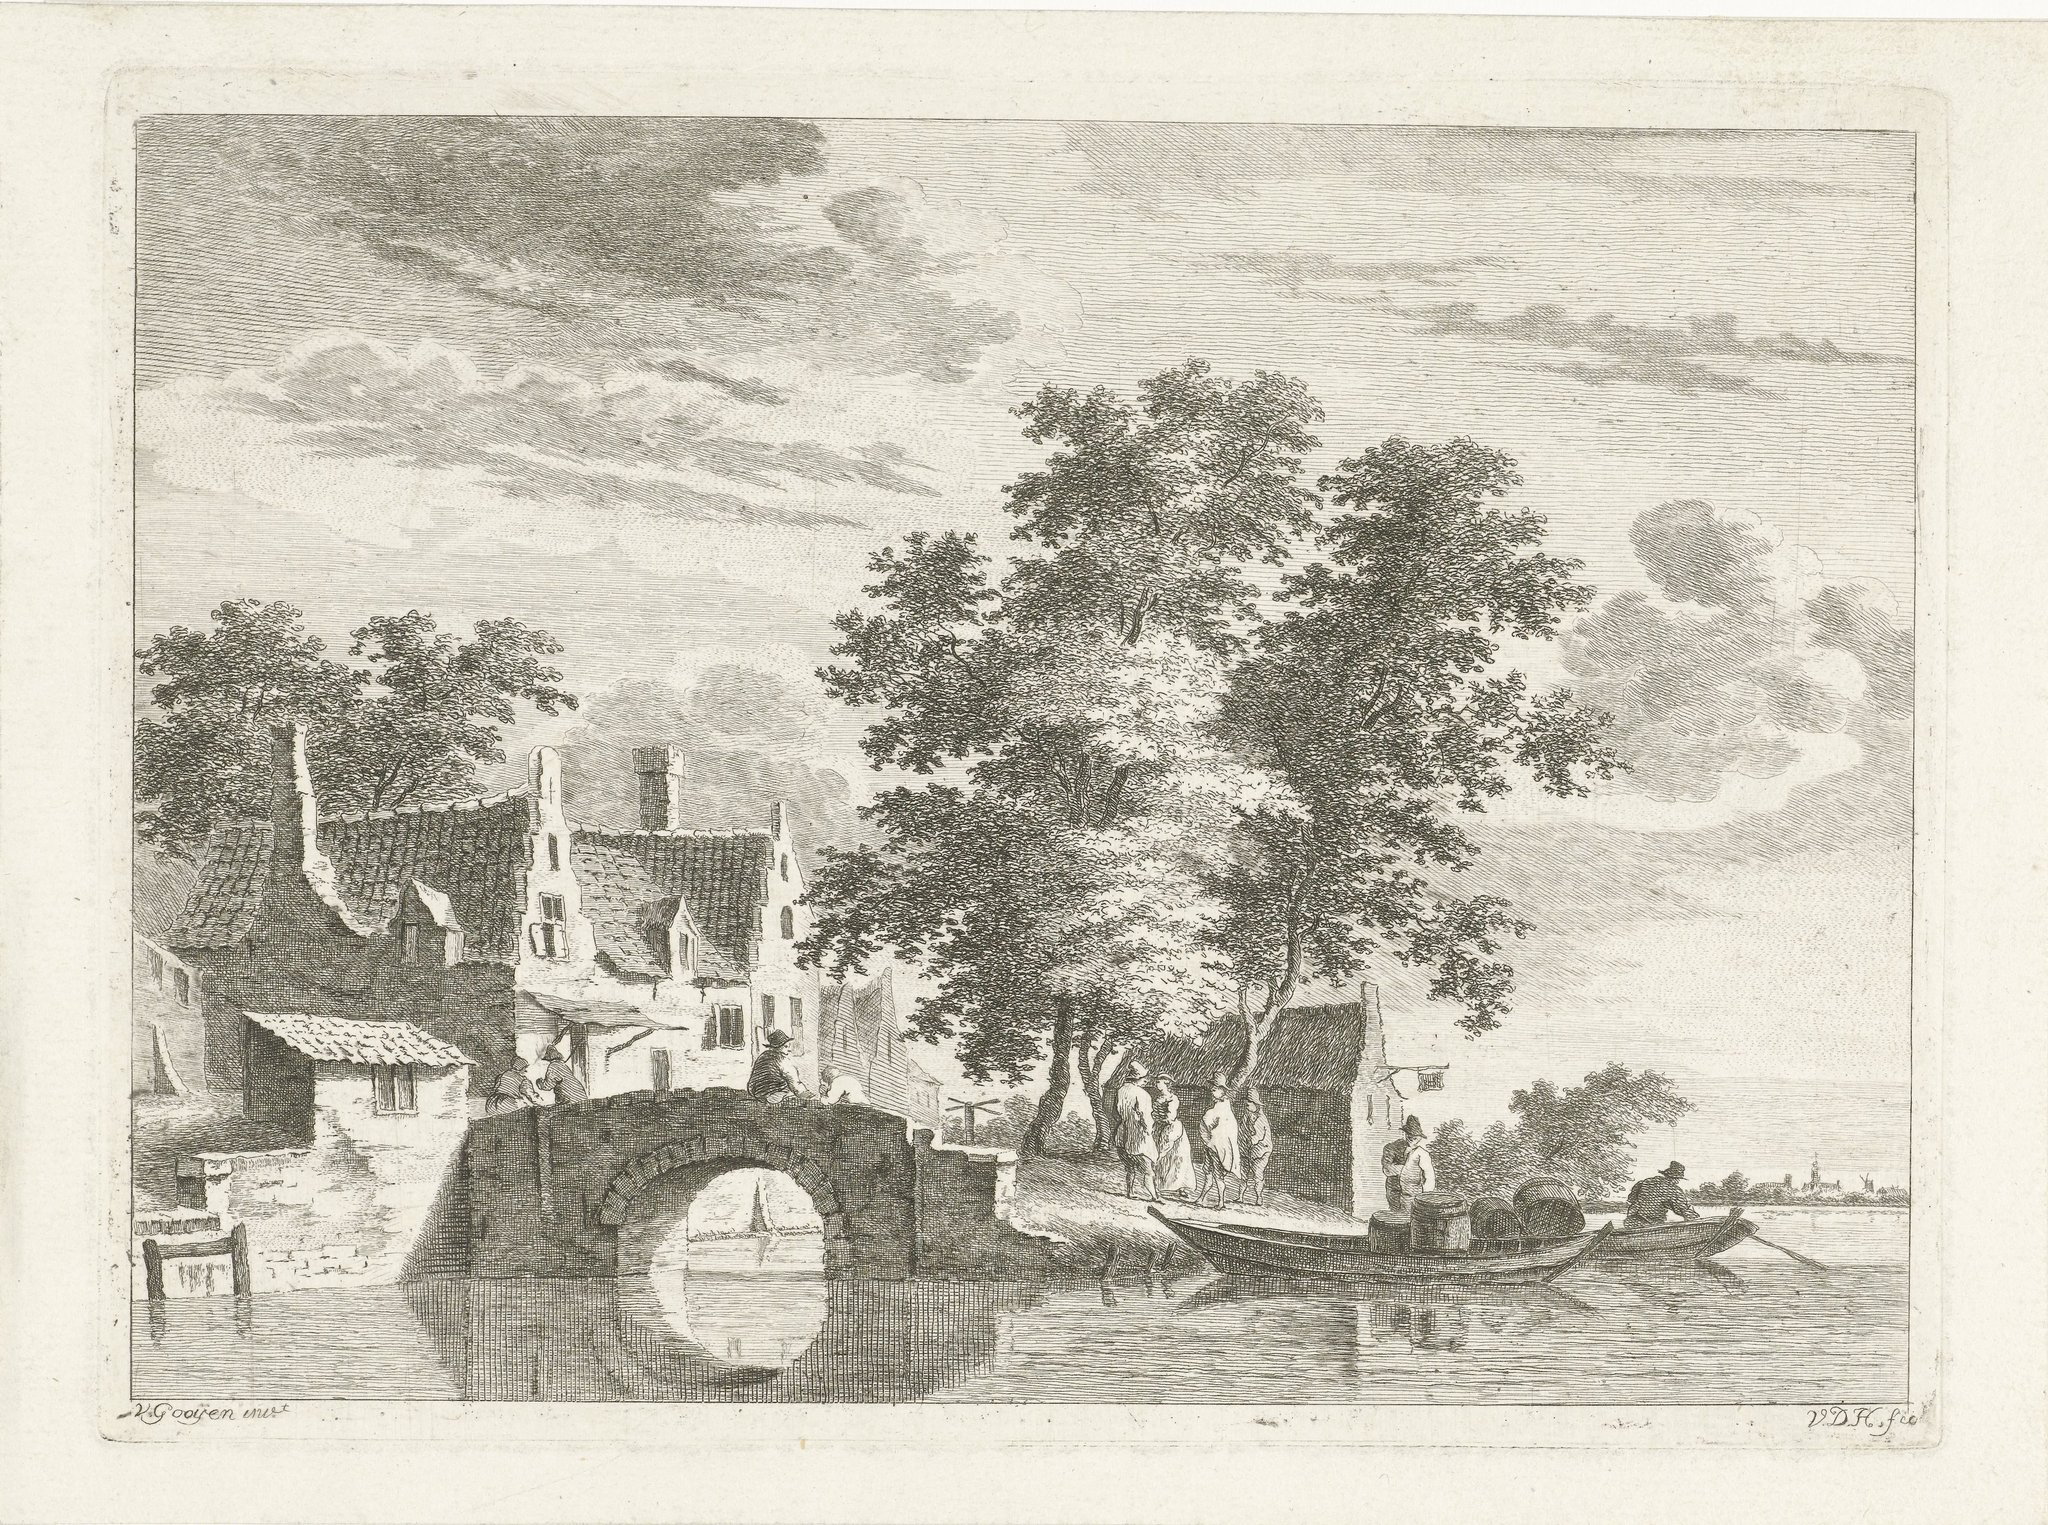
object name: print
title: Dorpsgezicht met stenen brug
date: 1745-1785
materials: paper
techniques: etching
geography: northern netherlands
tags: landscape with bridge, viaduct or aqueduct, village, rowing-boat, canoe, etc., landscapes with waters, waterscapes, seascapes (in the temperate zone) (+ landscape with figures, staffage)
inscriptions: collector's mark: Lugt 2228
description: Dorp langs een rivier, een aantal figuren op een stenen brug, rechts twee schuiten met tonnen.